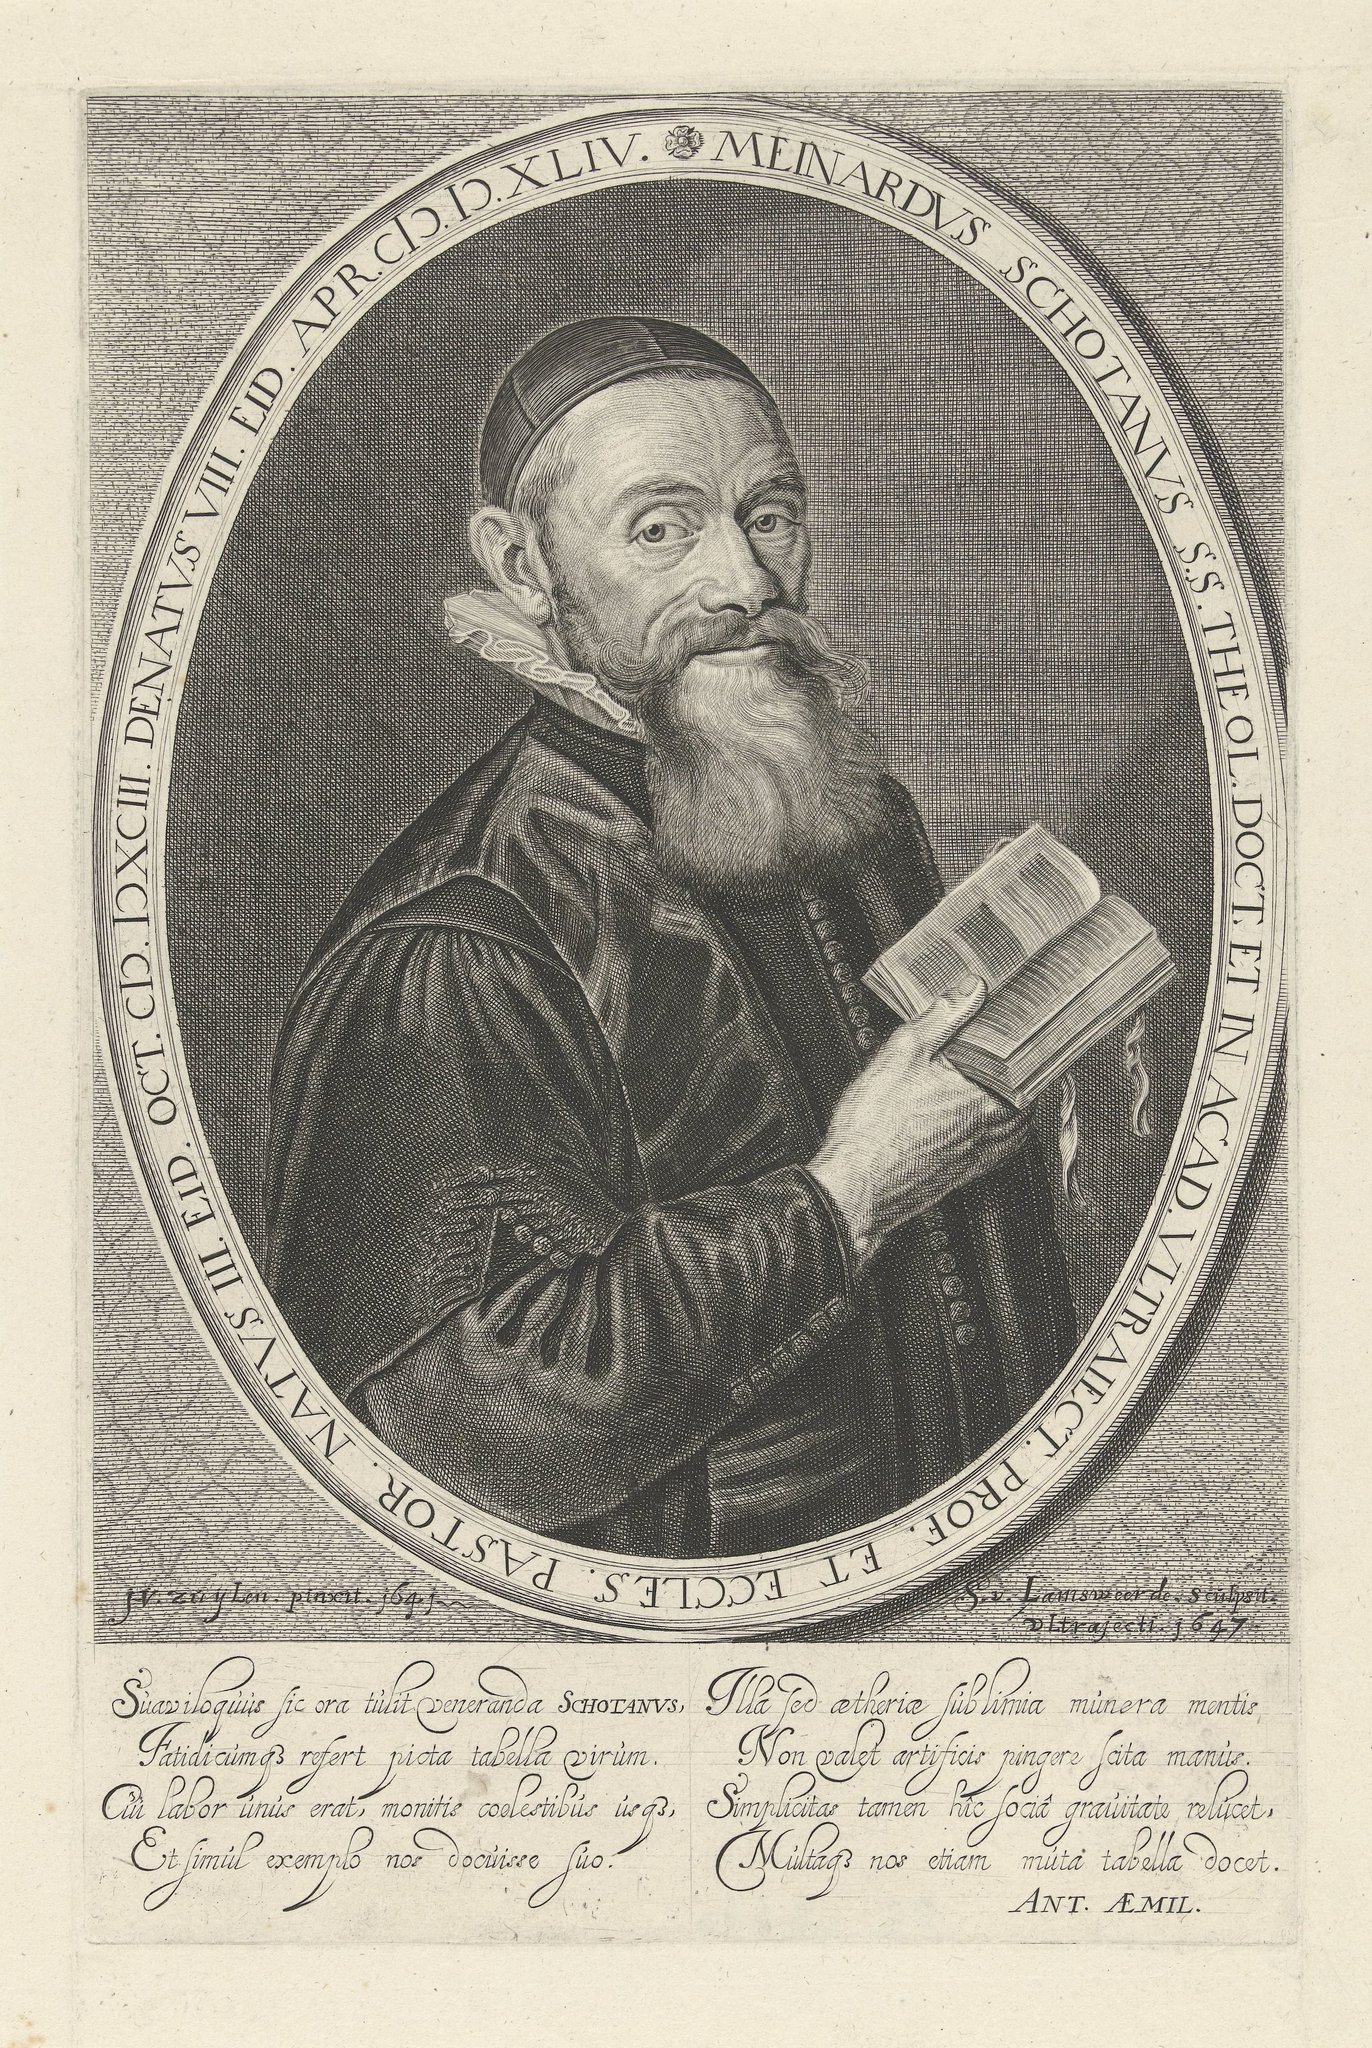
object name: print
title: Portret van Meinardus Schotanus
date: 1647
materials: paper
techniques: engraving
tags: meinardus schotanus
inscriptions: collector's mark: Lugt 240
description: Portret in ovaal en ten halven lijve naar rechts van Meinardus Schotanus, predikant en hoogleraar in de theologie te Utrecht. Op zijn hoofd een kalot, in zijn hand houdt Schotanus een opengeslagen boek. Op de ovale omlijsting staat een randschrift in Latijn, in de marge een achtregelig Latijns vers in twee kolommen.